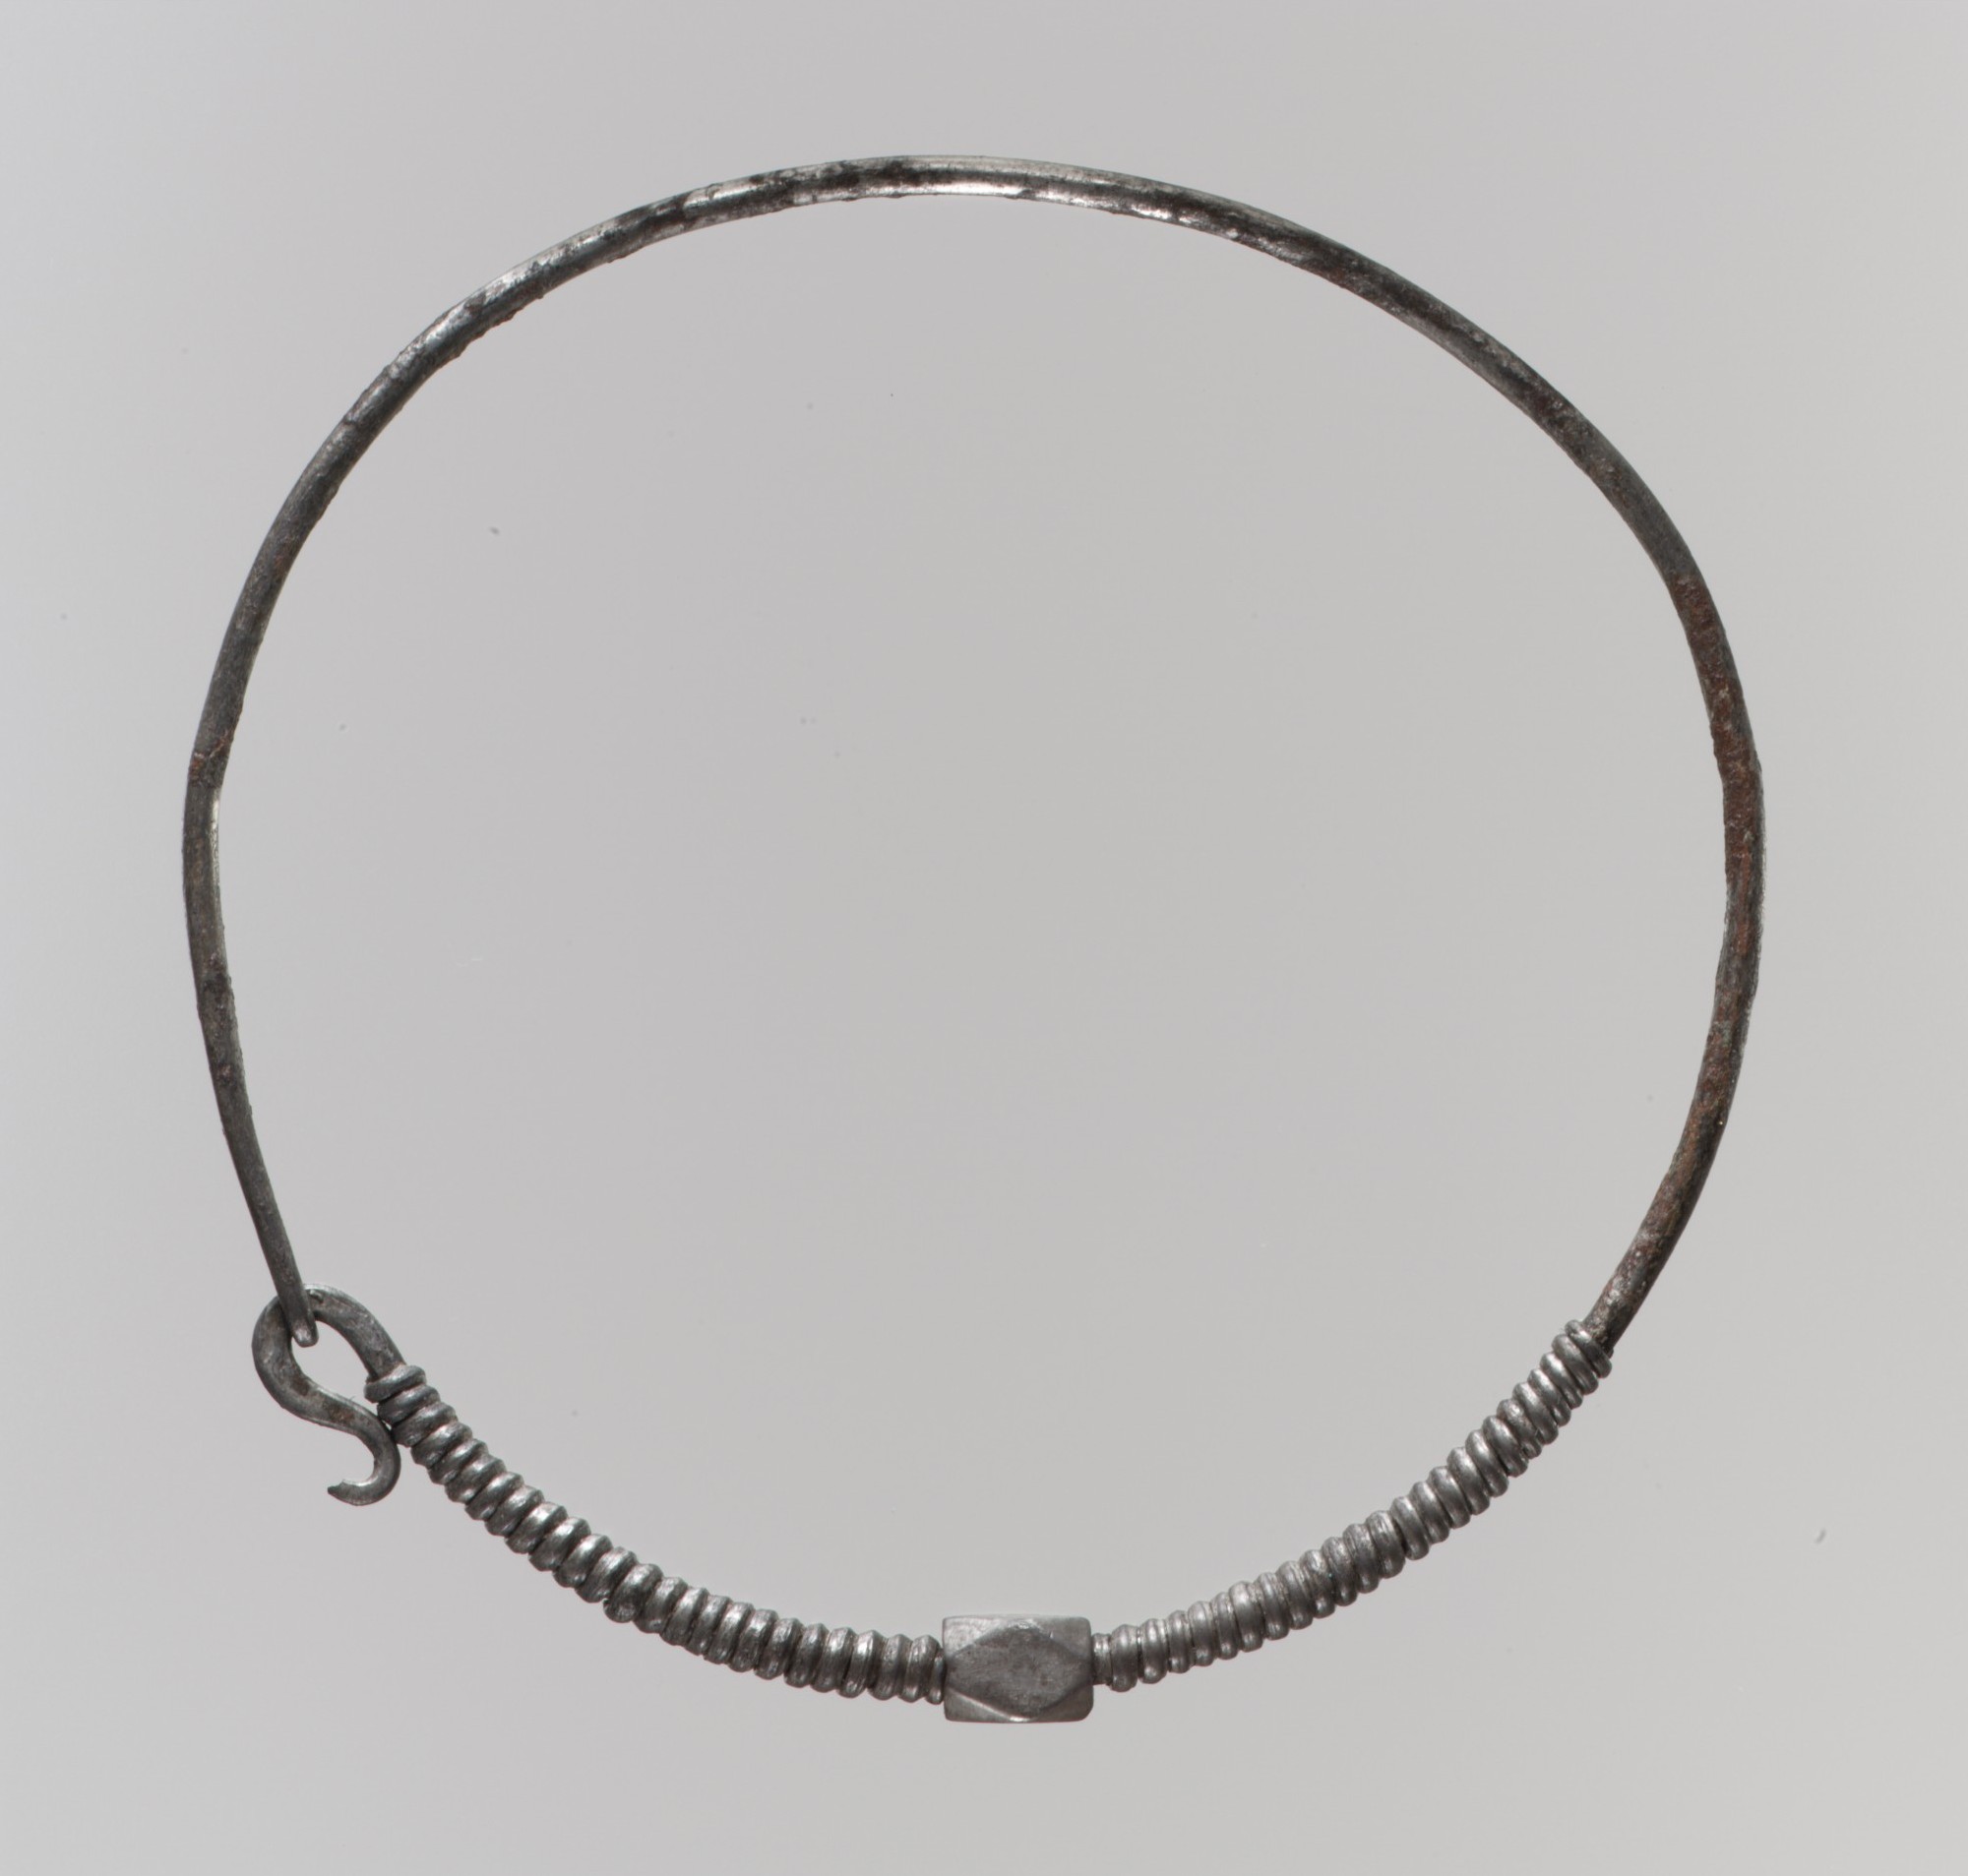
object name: earring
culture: frankish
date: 675-725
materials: silver